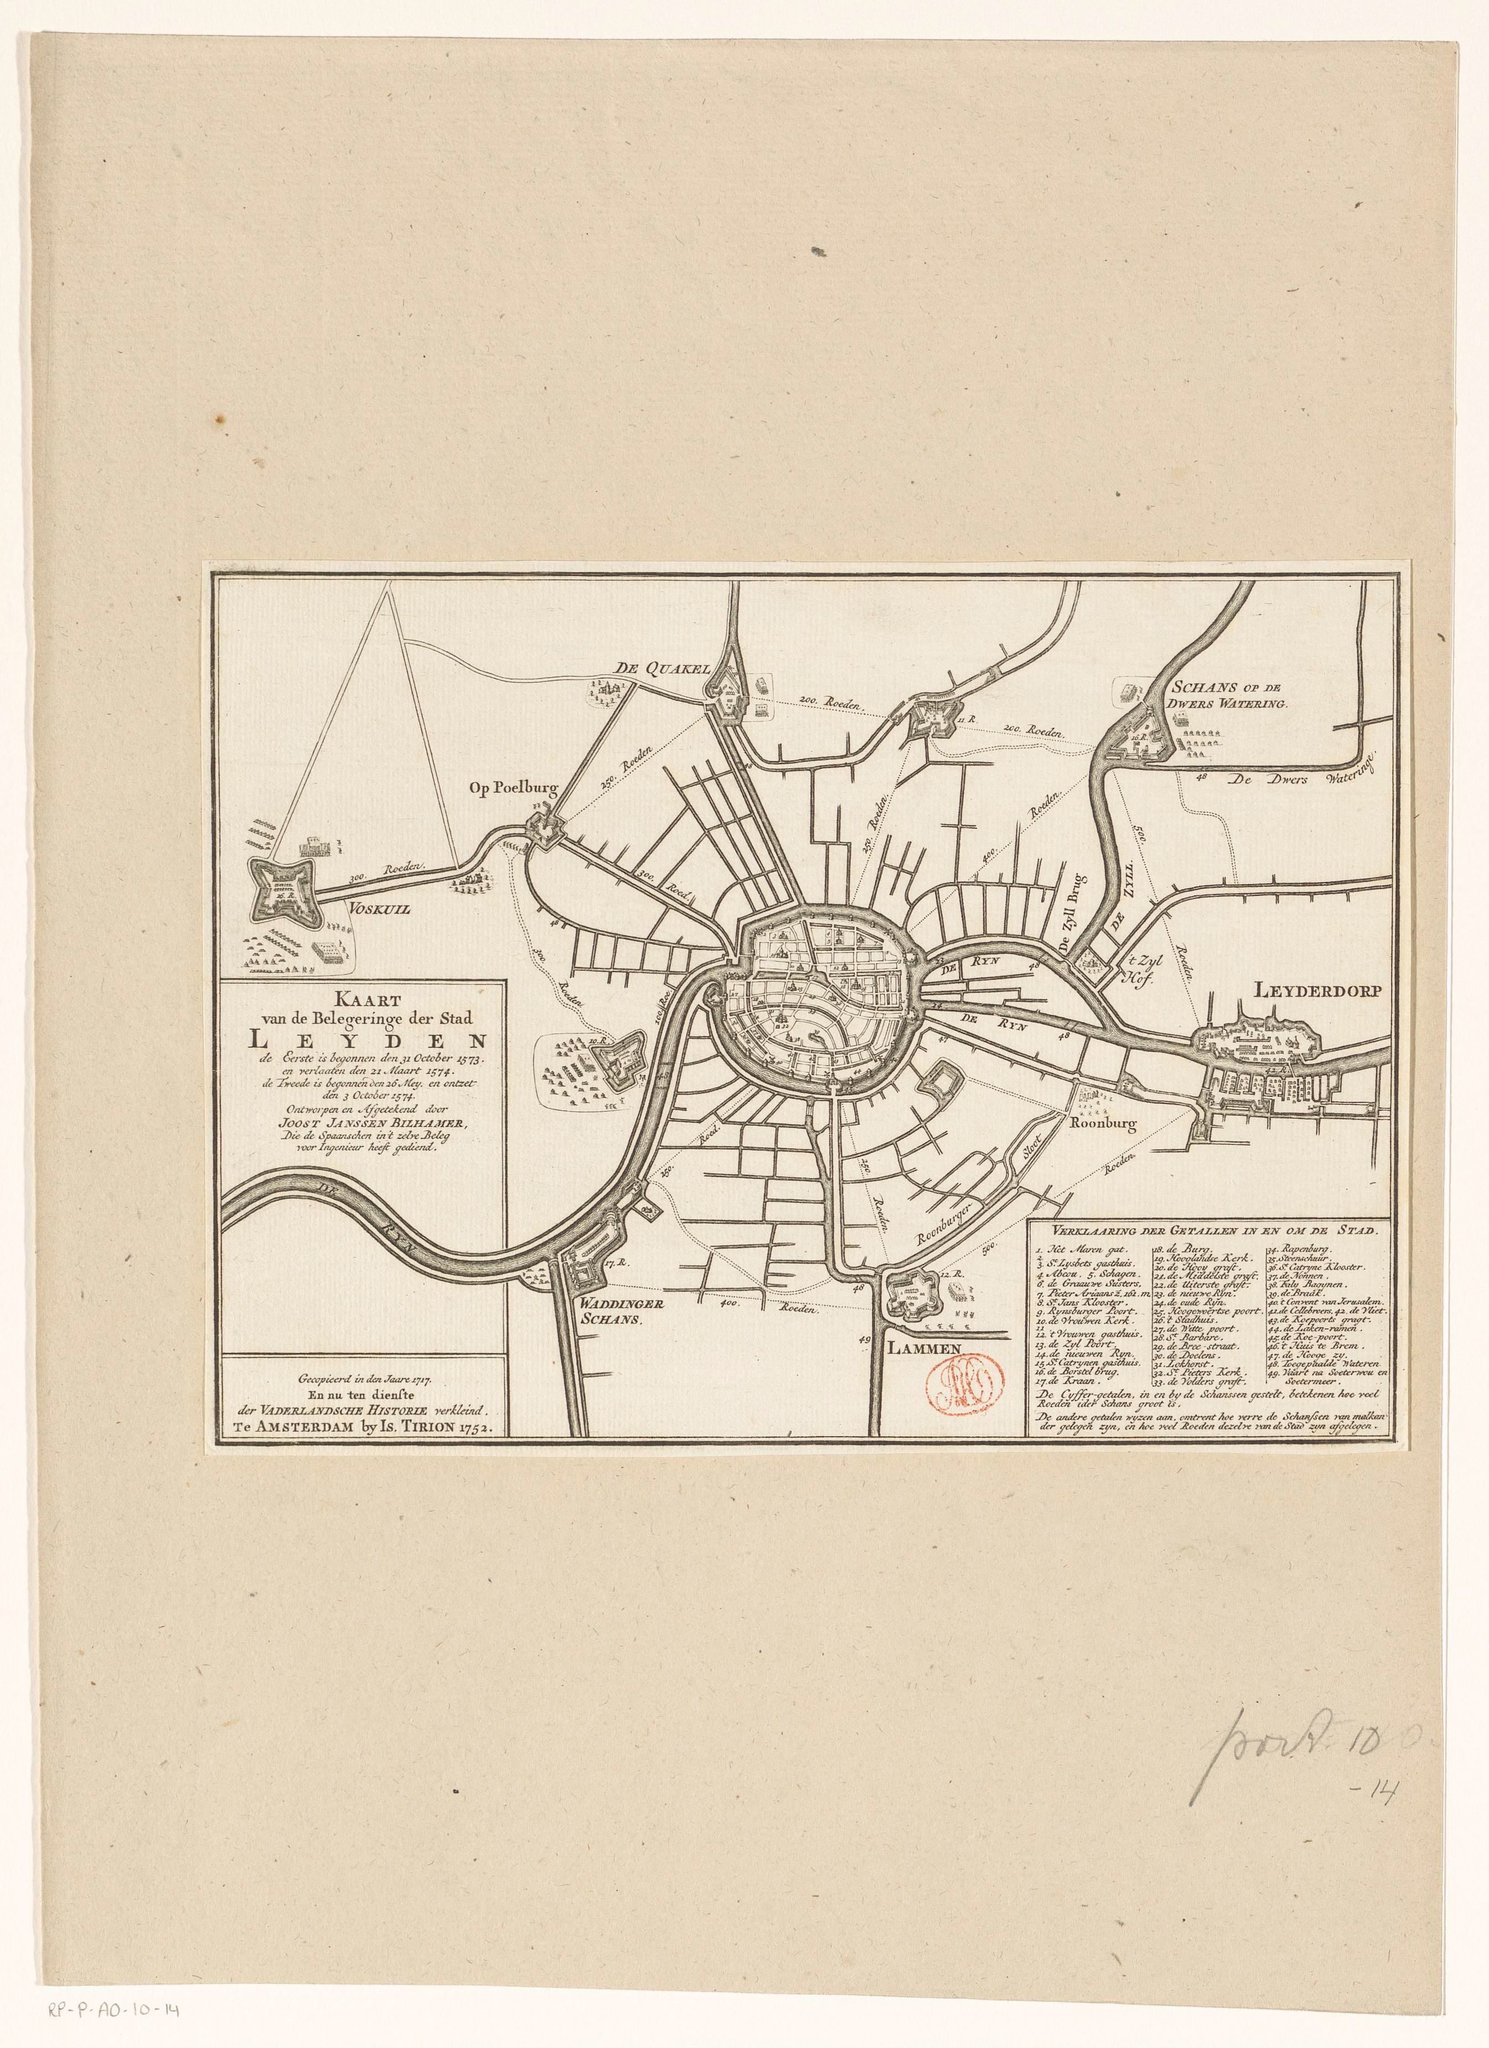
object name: print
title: Kaart van het beleg van Leiden, 1573-1574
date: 1752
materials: paper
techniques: engraving, etching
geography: northern netherlands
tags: maps of separate countries or regions, maps of cities, leiden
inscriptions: collector's mark: Lugt 195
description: Belegeringen van de stad Leiden in de jaren 1573-1574 door de Spanjaarden. Kaart met plattegrond van de stad en de omgeving tot Leiderdorp en De Kwakel, met alle schansen in de omgeving. Links een cartouche met de titel en informatie over het beleg, rechts een cartouche met de legenda 1-49 in het Nederlands.